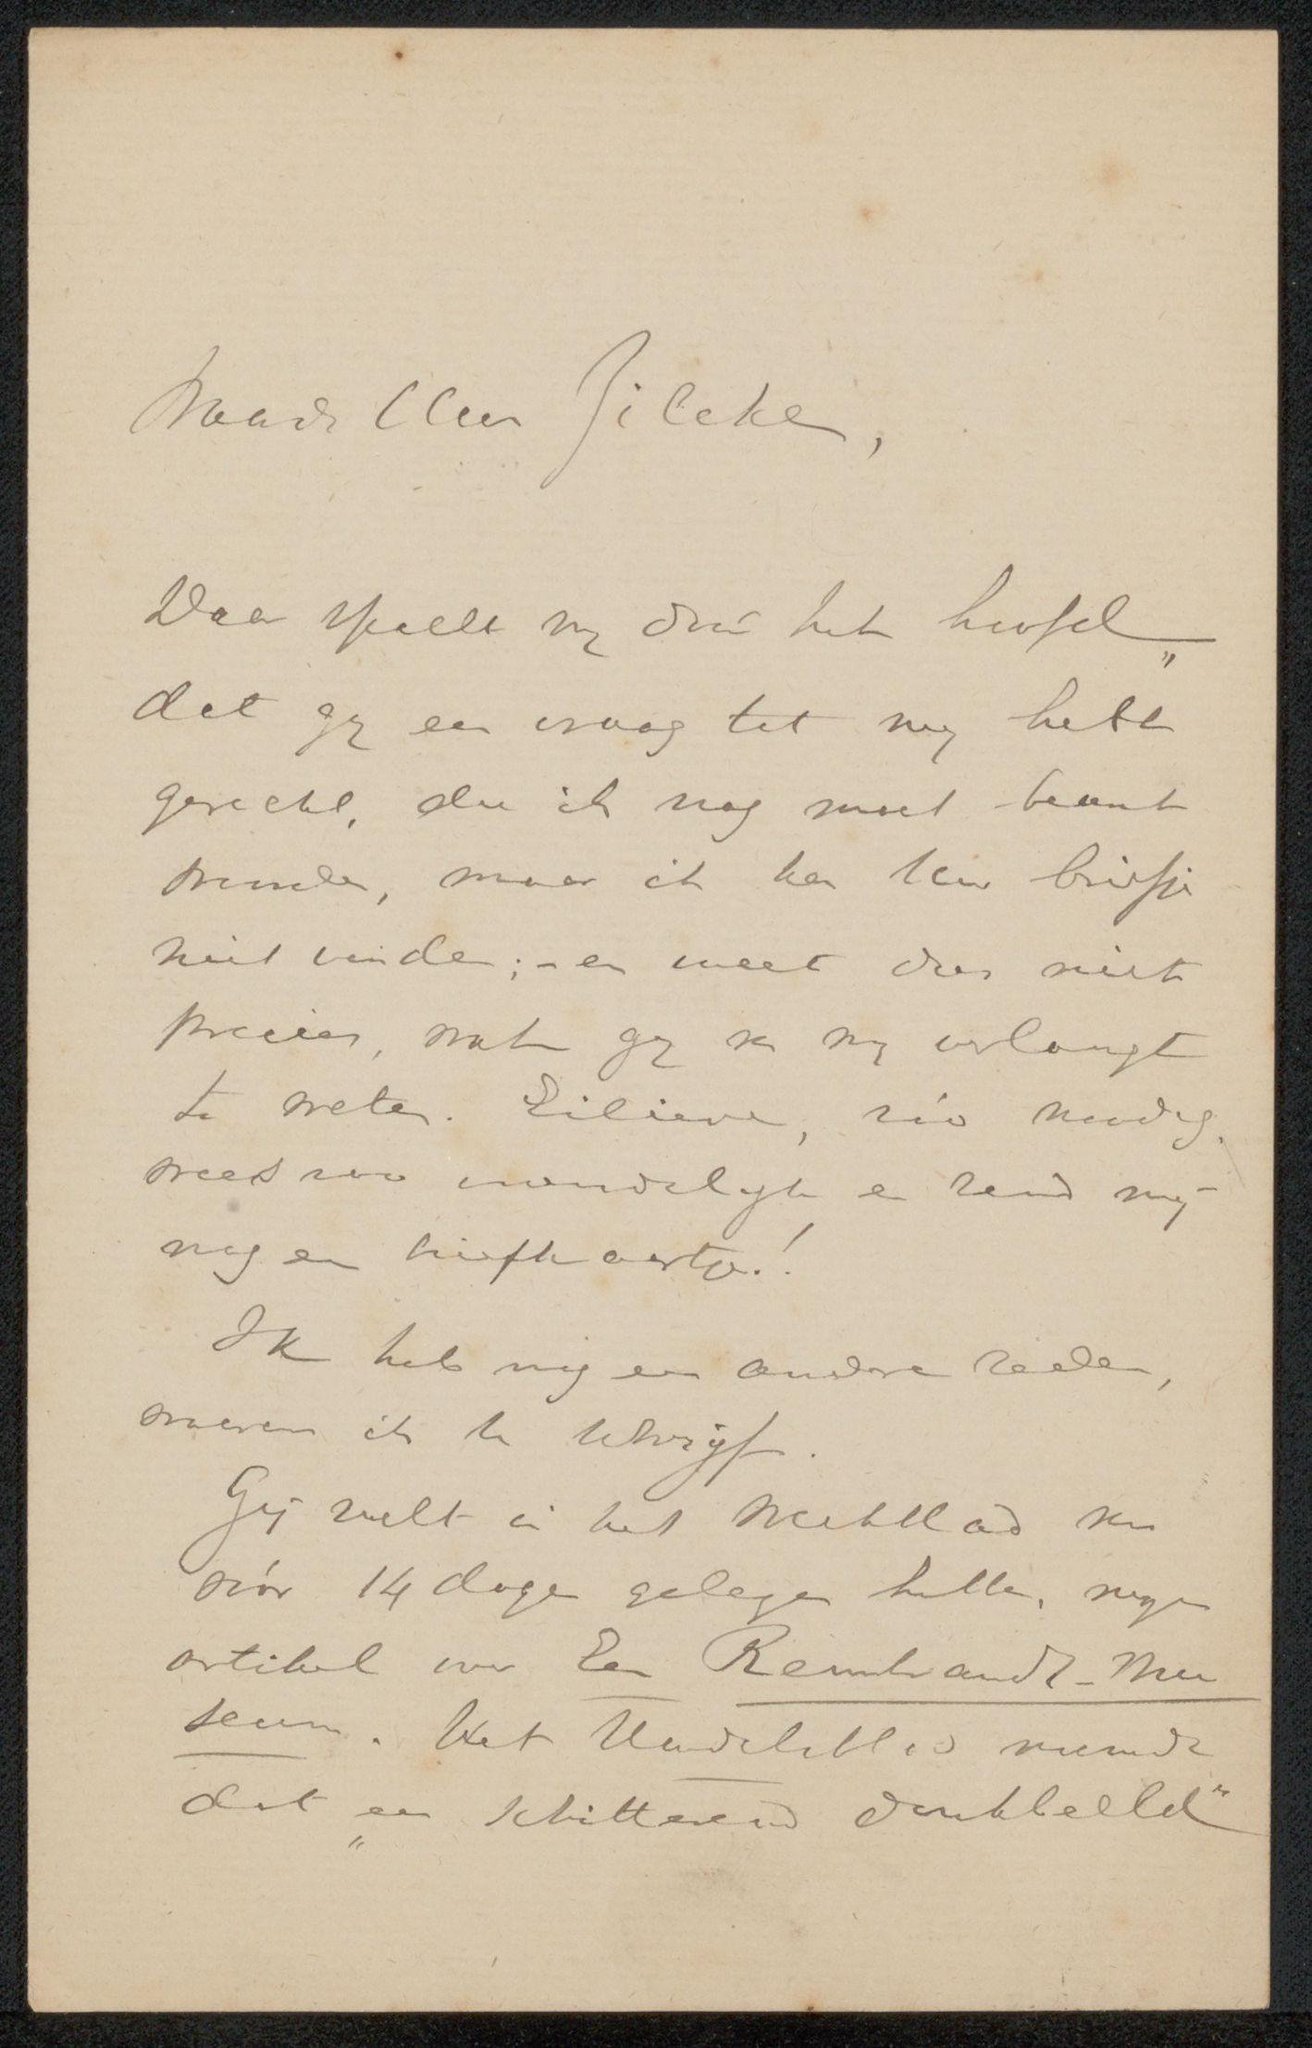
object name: letter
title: Brief aan Philip Zilcken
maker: johannes de koo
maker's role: auteur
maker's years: 1841-1909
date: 1896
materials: ink, paper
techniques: pen, writing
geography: hilversum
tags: painter, léon bonnat, leiden, print maker, draughtsman, rembrandt van rijn, philip zilcken, permanent exhibition, museum, art collecting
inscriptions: collector's mark: ‘RPK’